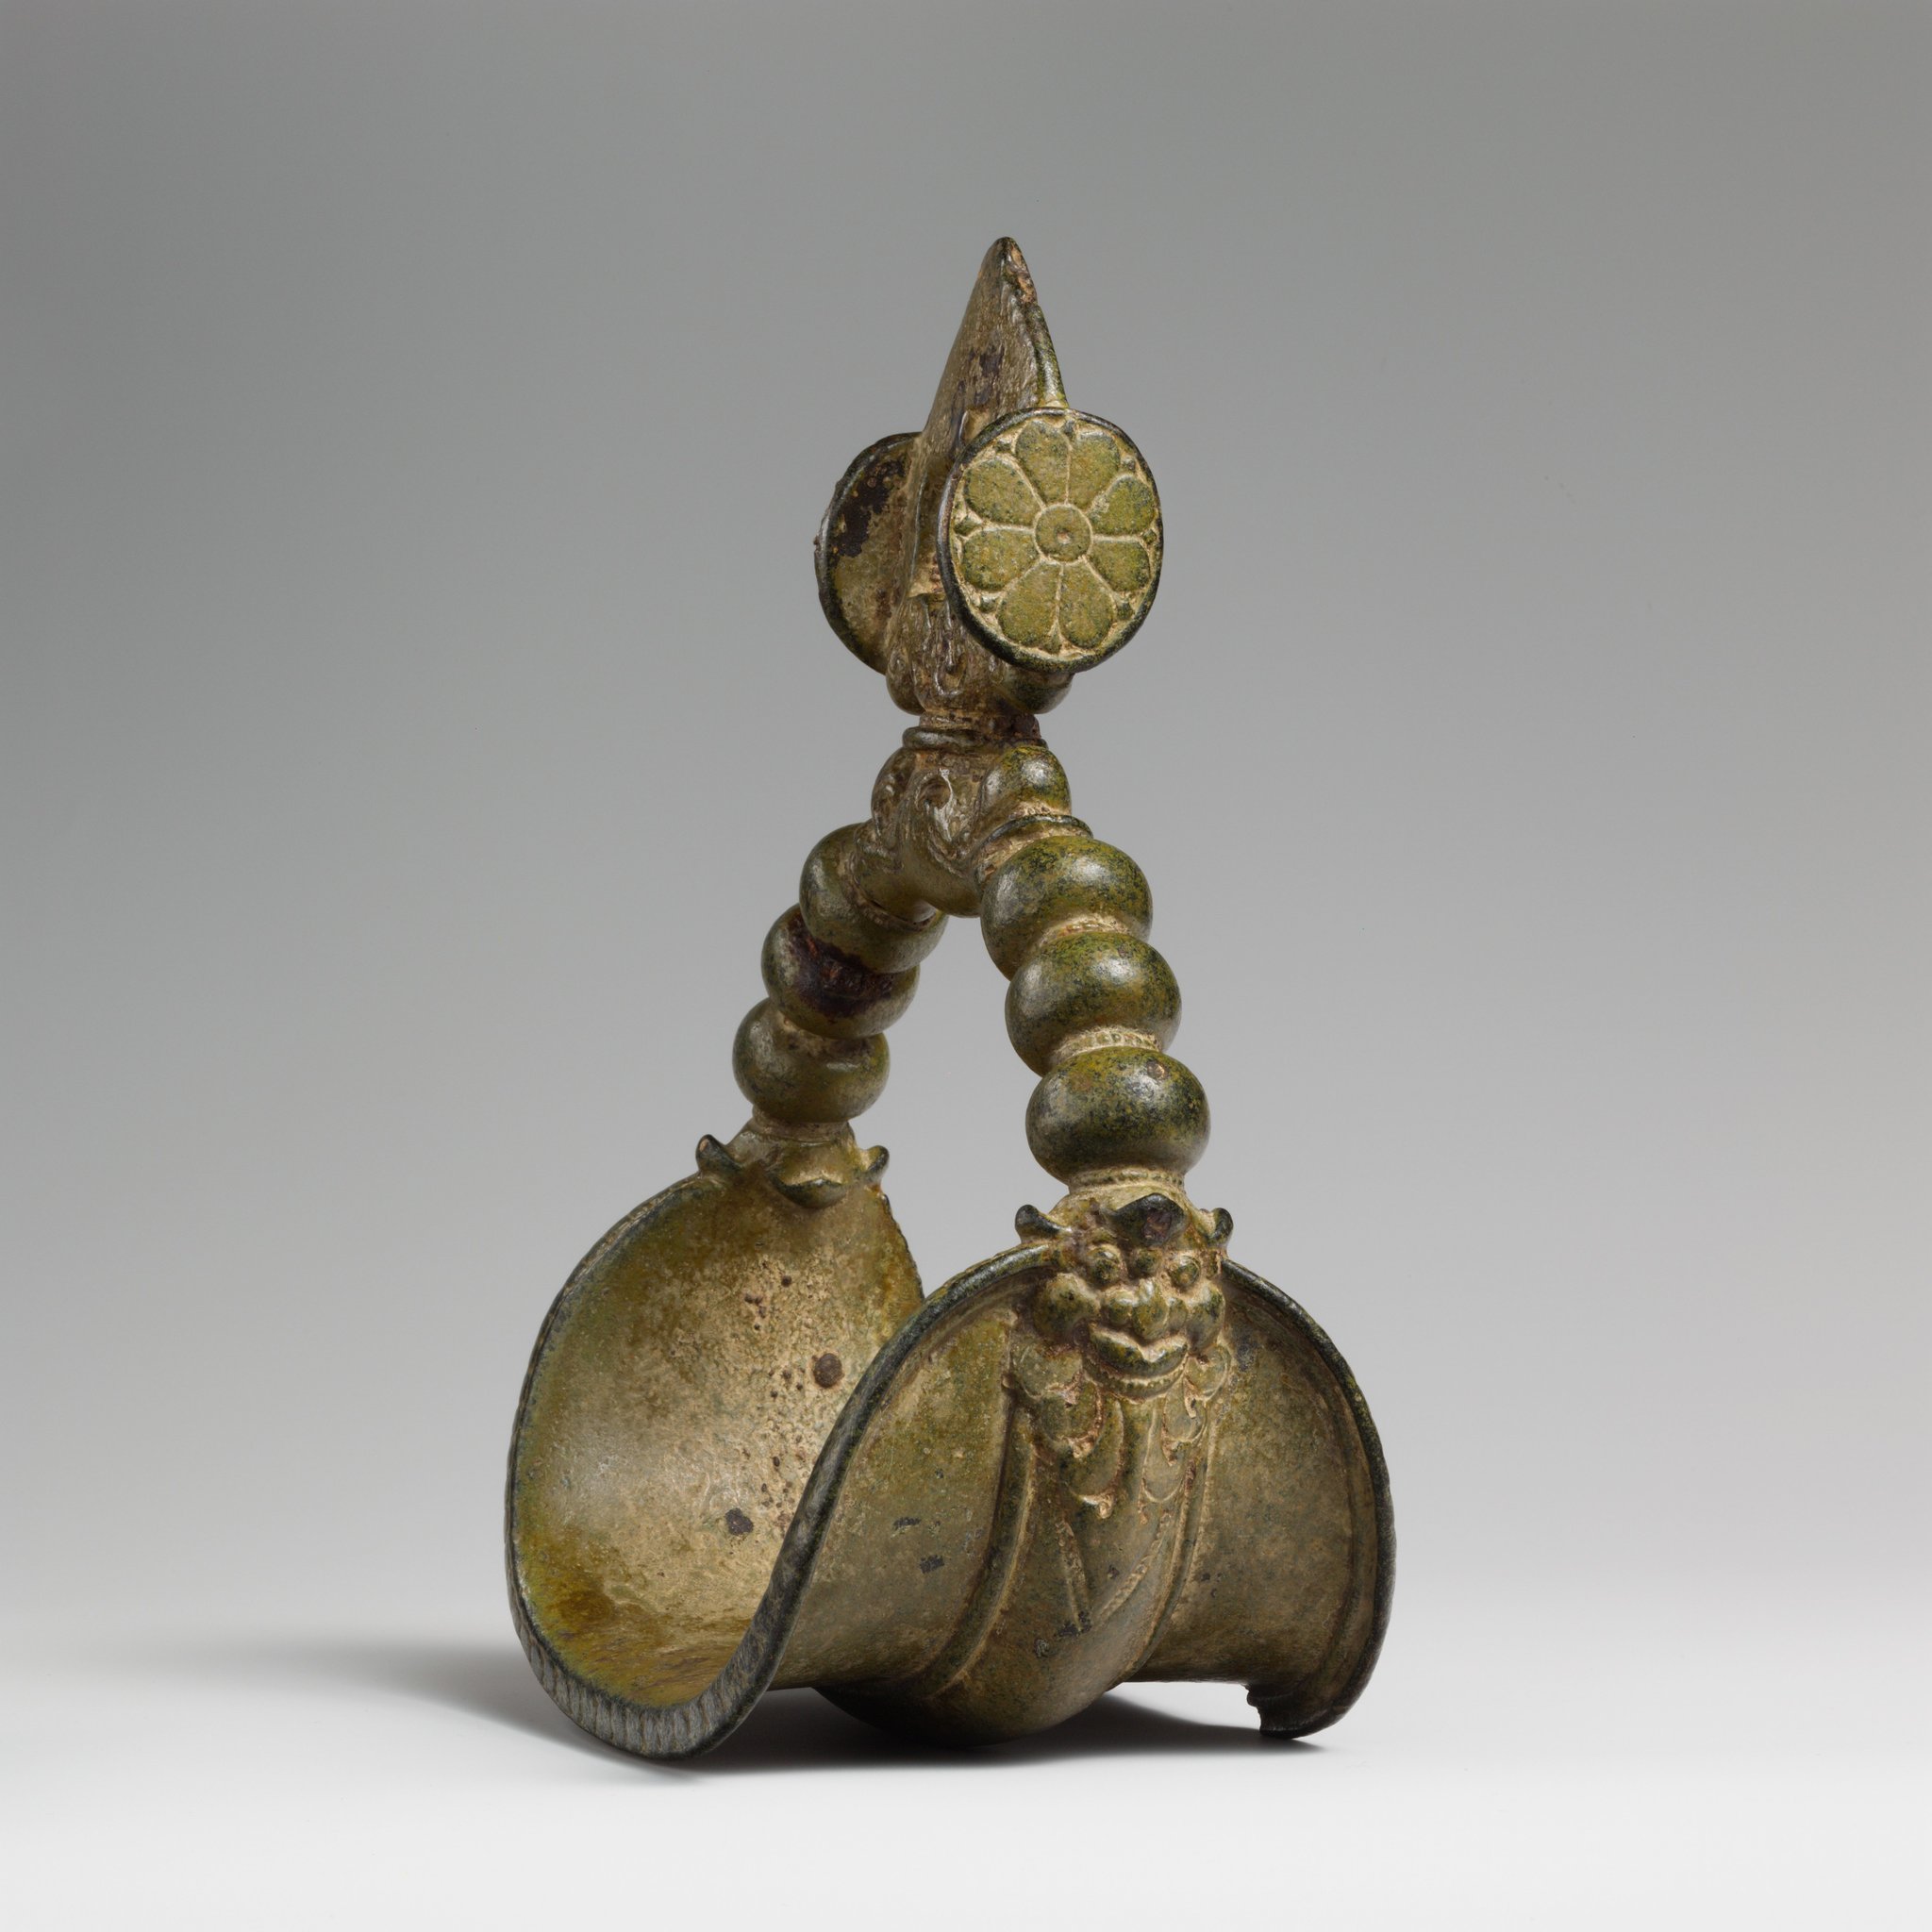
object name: stirrup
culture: burmese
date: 1101-1400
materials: copper alloy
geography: indonesia